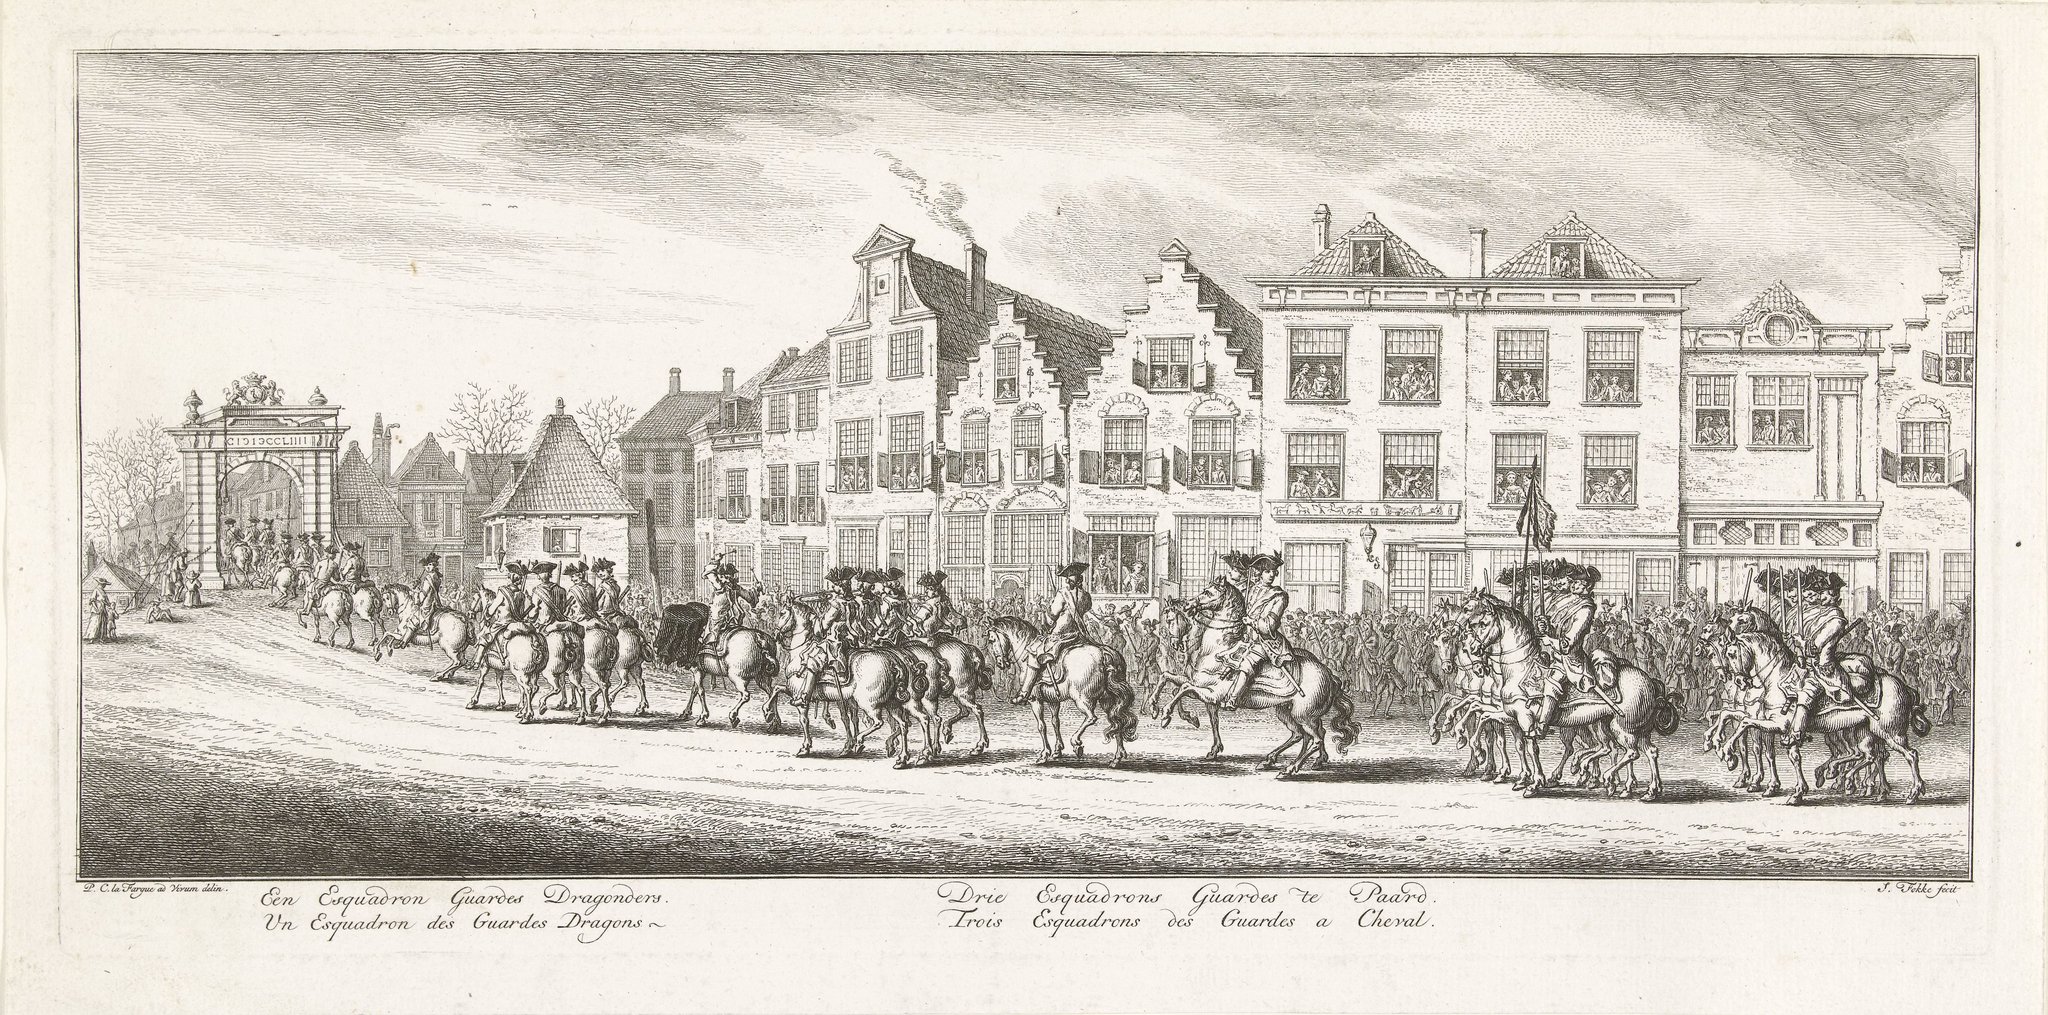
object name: print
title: Lijkstoet van prinses Anna van Hannover te Delft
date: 1759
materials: paper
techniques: engraving, etching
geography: northern netherlands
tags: the hague, anna van hannover, cortege, funeral procession, delft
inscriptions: collector's mark: Lugt 2228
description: Gardes Dragonders en gardes te paard, voorafgegaan door trompetters en trommelslagers. Aankomst bij de Haagse Poort te Delft. Onderdeel van een serie van 16 platen plus een gedrukte beschrijving van de lijkstatie van de op 23 februari 1759 te Delft begraven prinses Anna van Hannover. Ongenummerd.